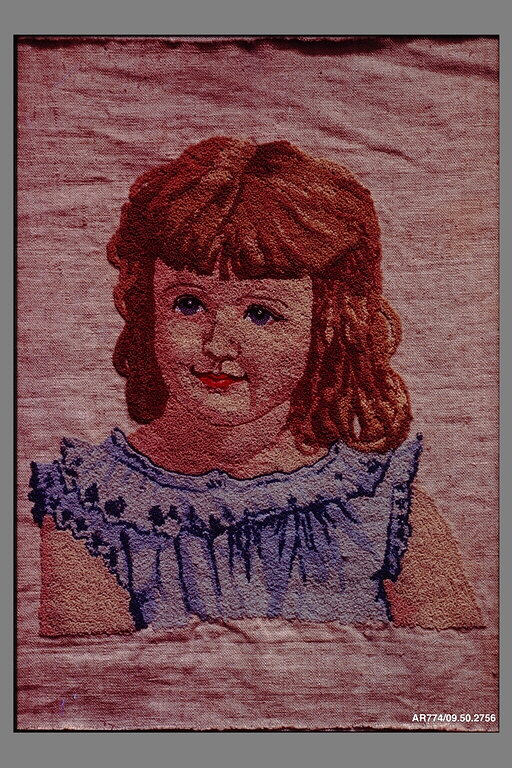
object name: portrait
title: Portrait of a child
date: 1801-1900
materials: canvas, wool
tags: girls,portraits